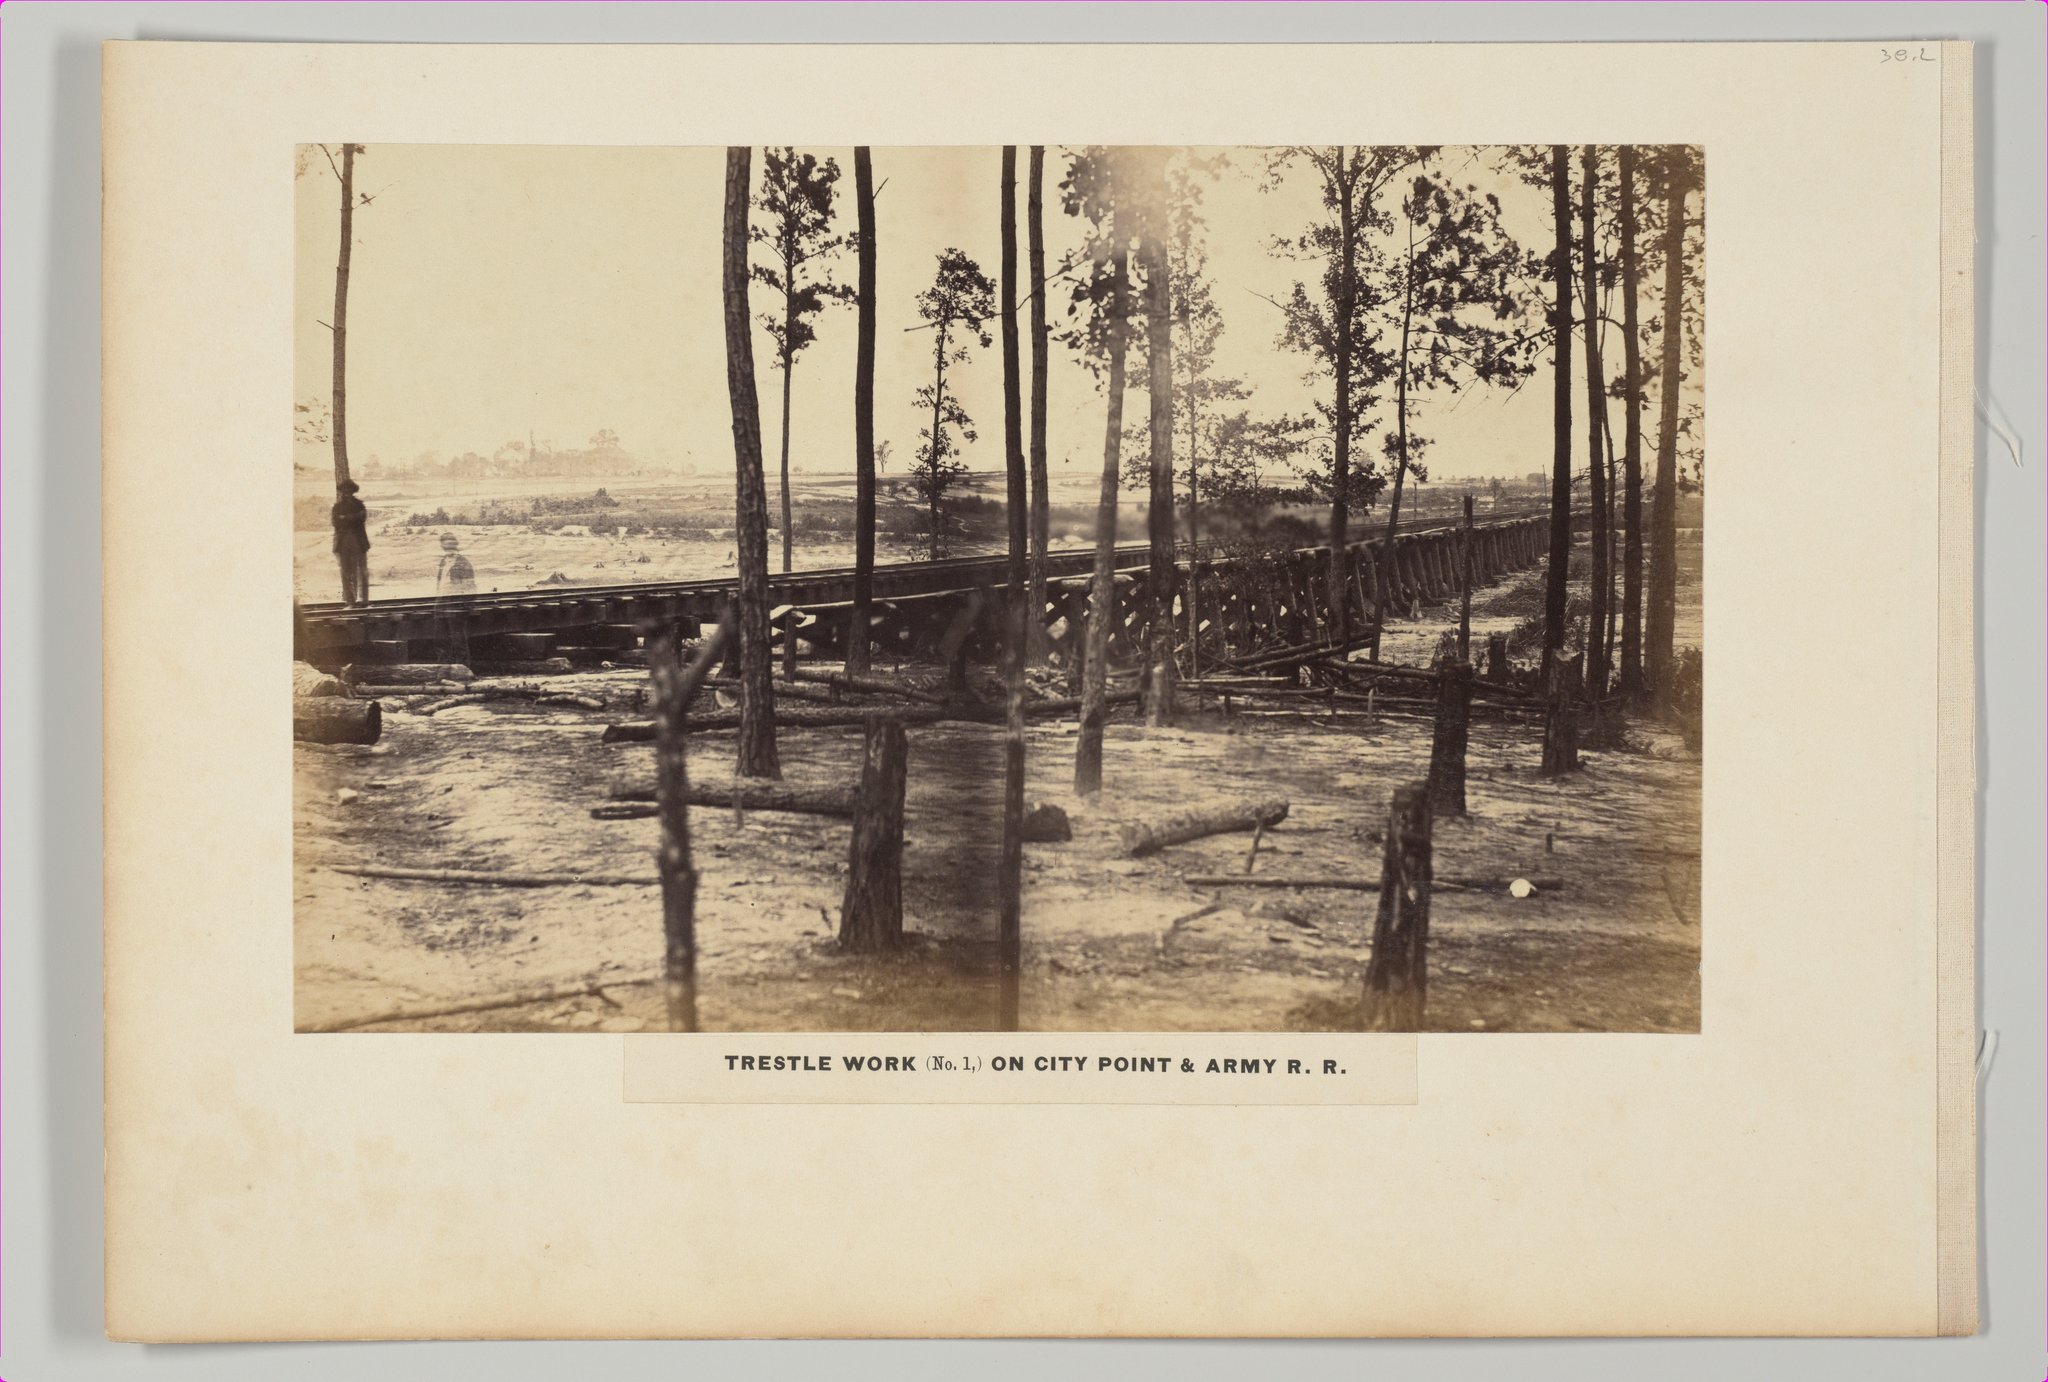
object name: photograph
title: Trestle Work (No. 1) on City Point & Army Rail Road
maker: andrew joseph russell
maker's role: artist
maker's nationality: american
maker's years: 1830-1902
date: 1863-1864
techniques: albumen silver print, glass negative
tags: railways,american civil war